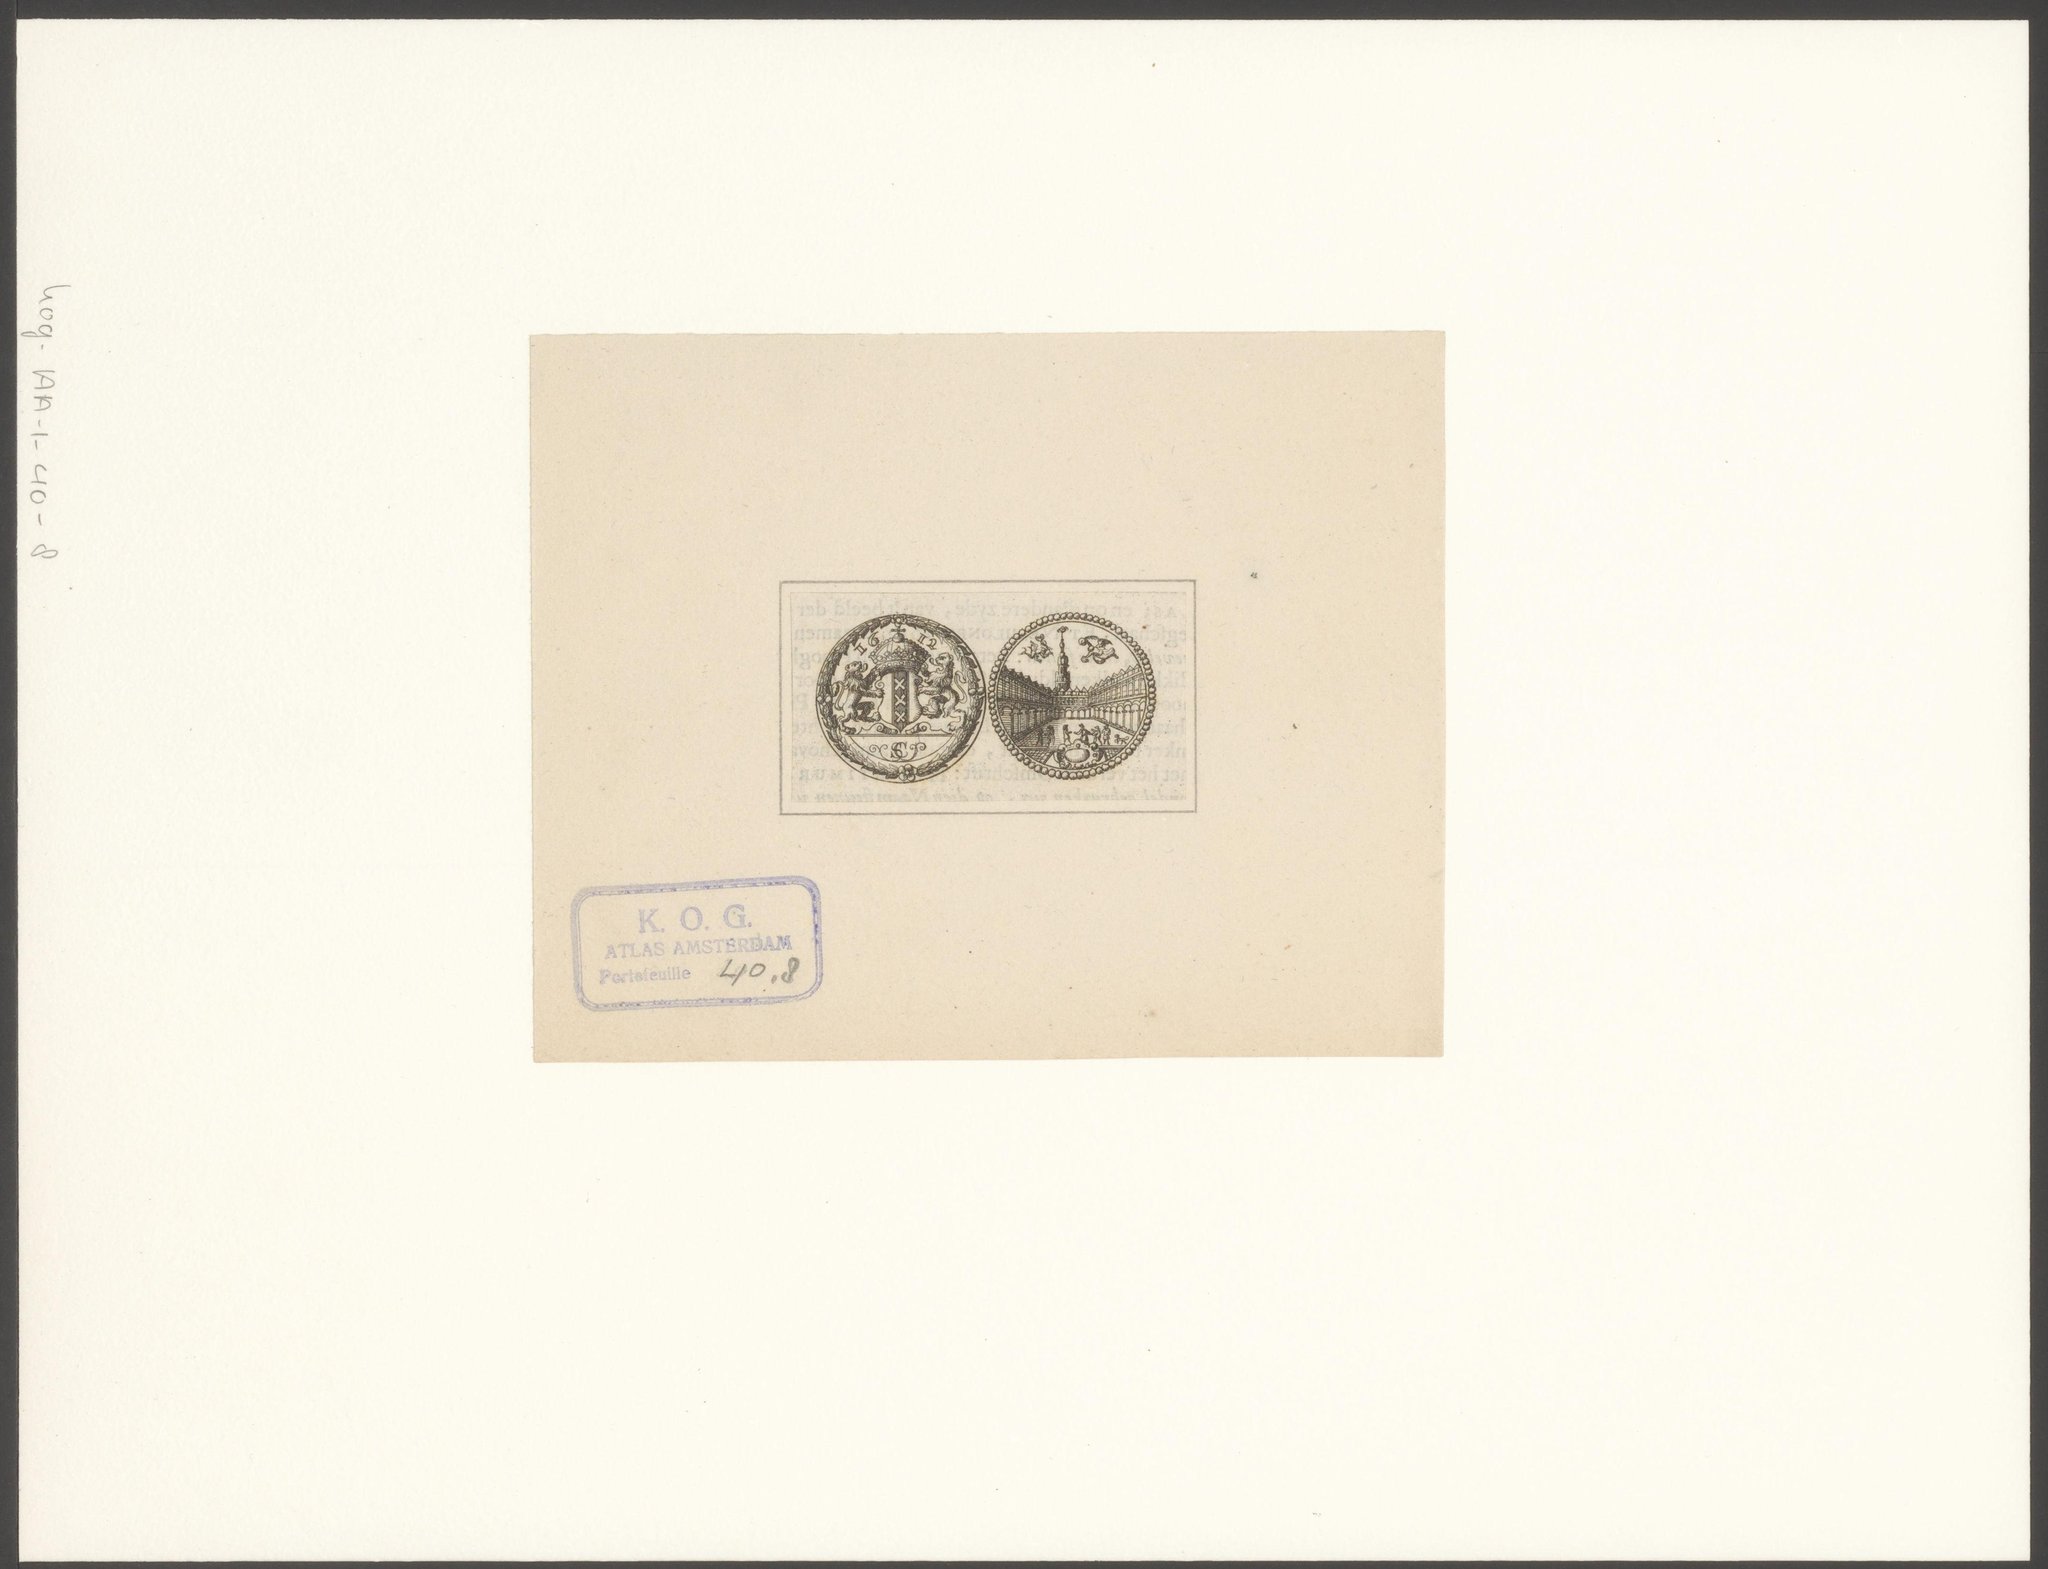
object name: book illustration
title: Penning op de opening van de Beurs van Hendrik de Keyser te Amsterdam in 1612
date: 1690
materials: paper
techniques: etching, letterpress printing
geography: amsterdam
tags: coat of arms (as symbol of the state, etc.) (+ city; municipal), memorial medal, stock exchange, stock-market, courtyard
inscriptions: collector's mark: Lugt 1641b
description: Prent uit: Bizot, Pierre. Medalische Historie der Republyk van Holland. Amsterdam: Pieter (I) Mortier, 1690, p. 103(*3).